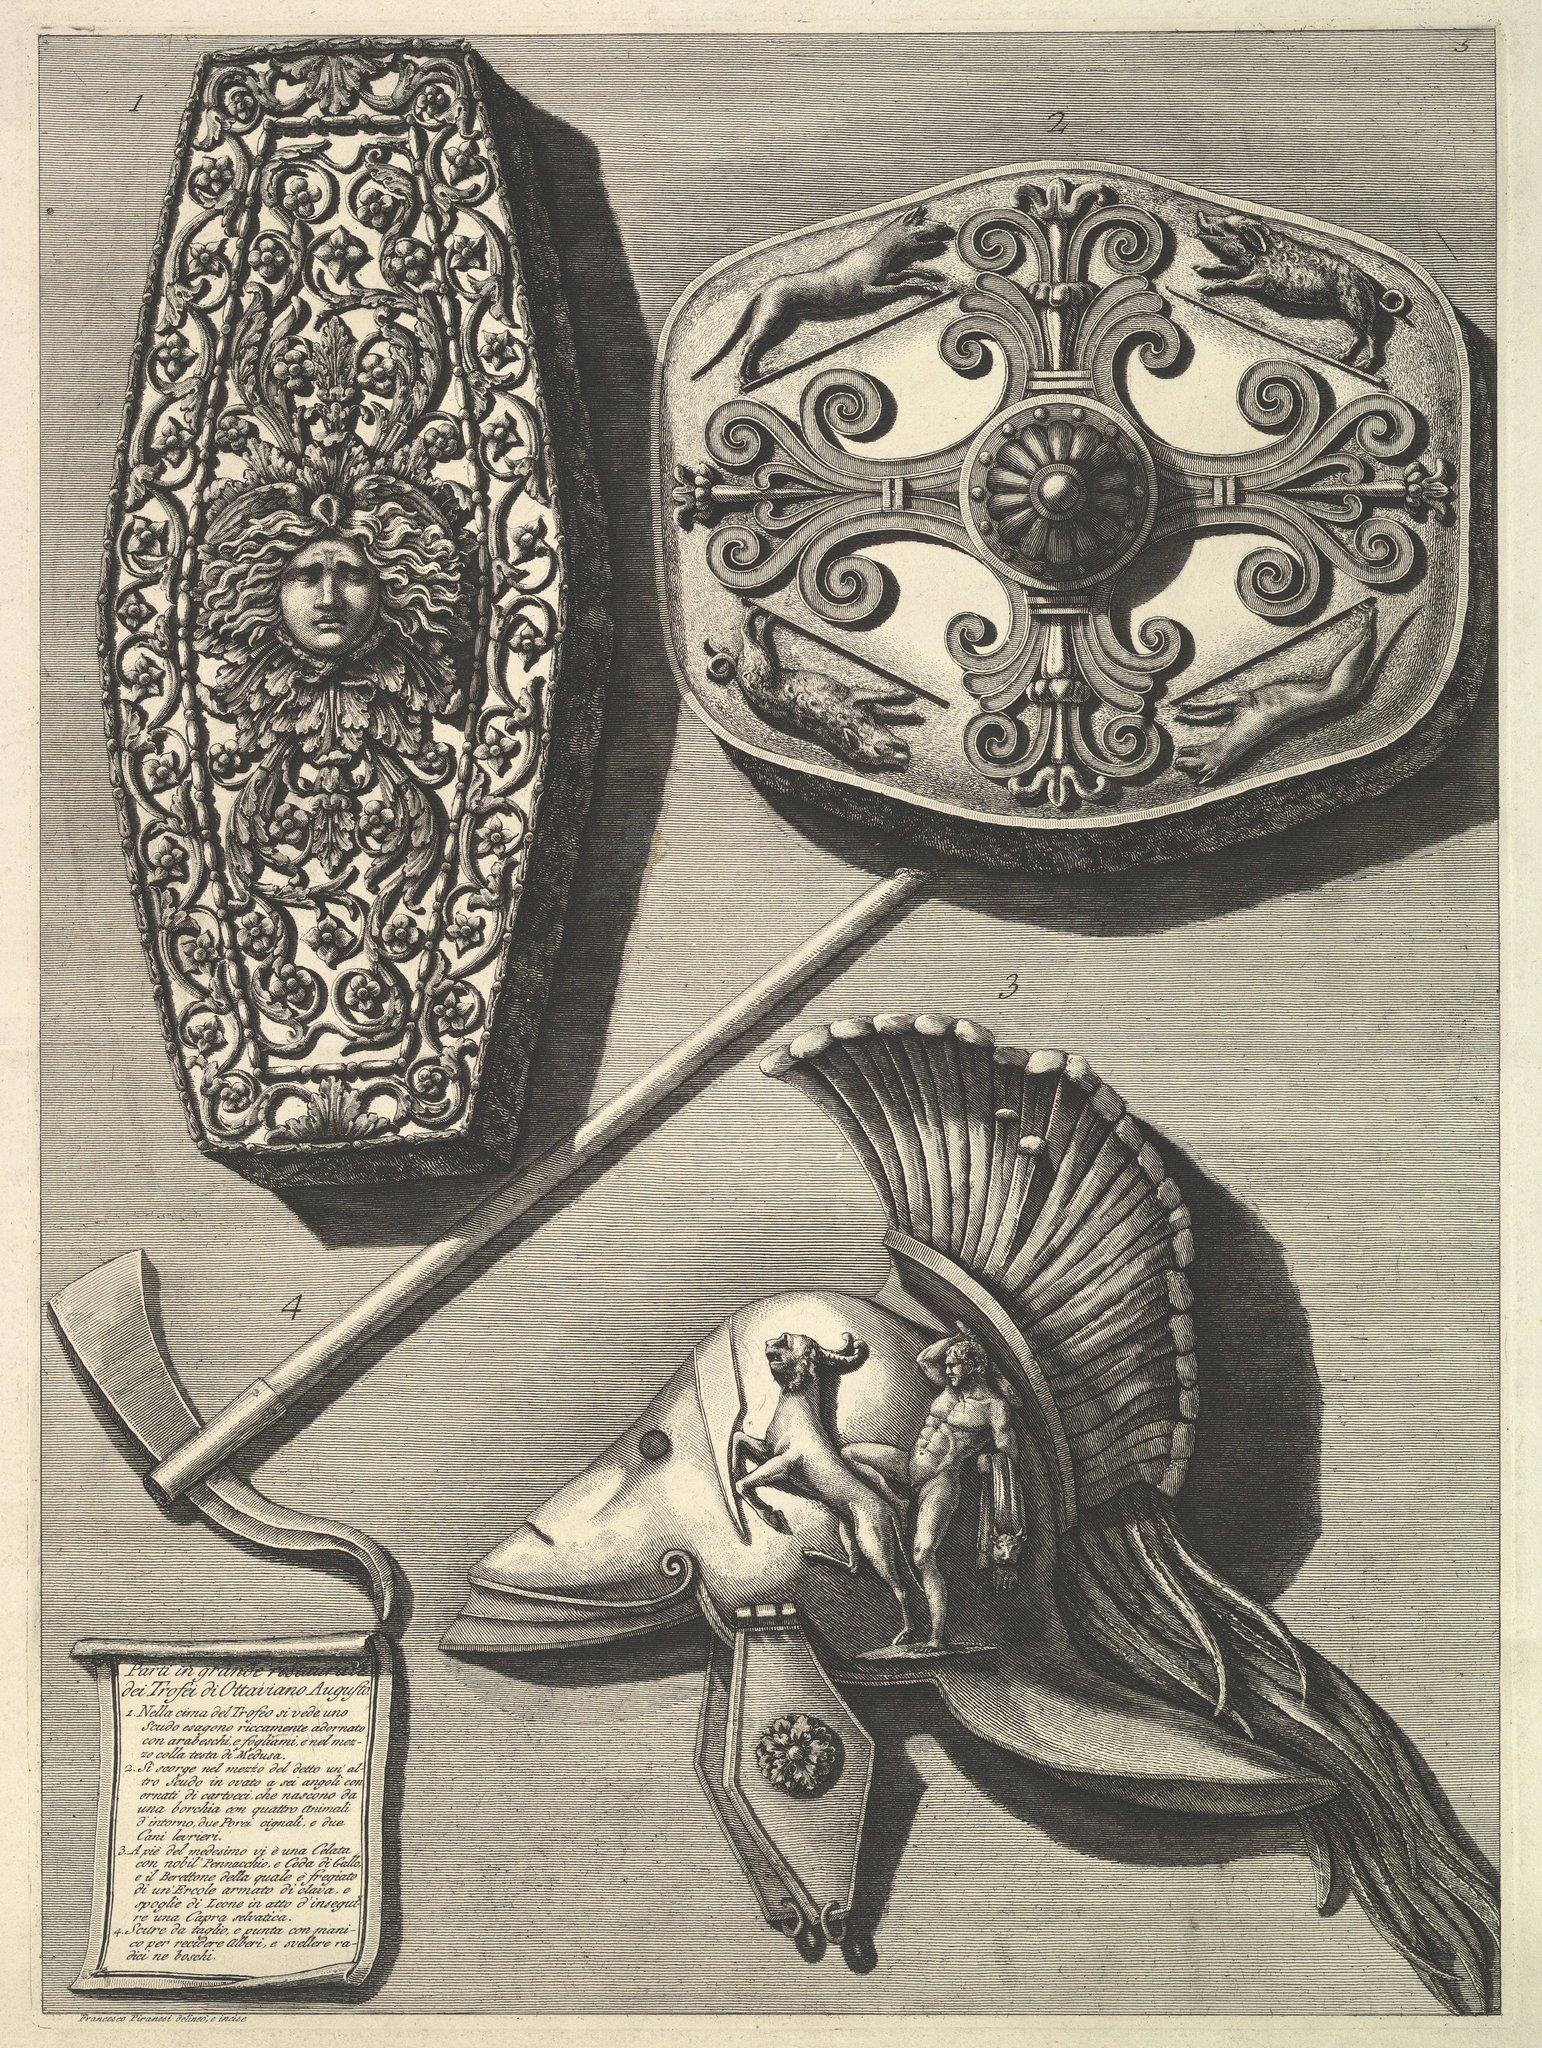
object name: print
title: Parti in grande restaurati de' Trofei de Ottaviano Augusto (Restored detail of the Trophy of Octavian Augusto)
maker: francesco piranesi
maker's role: artist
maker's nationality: italian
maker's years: 1758-1810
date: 1753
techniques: etching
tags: animals,helmets,male nudes,axes